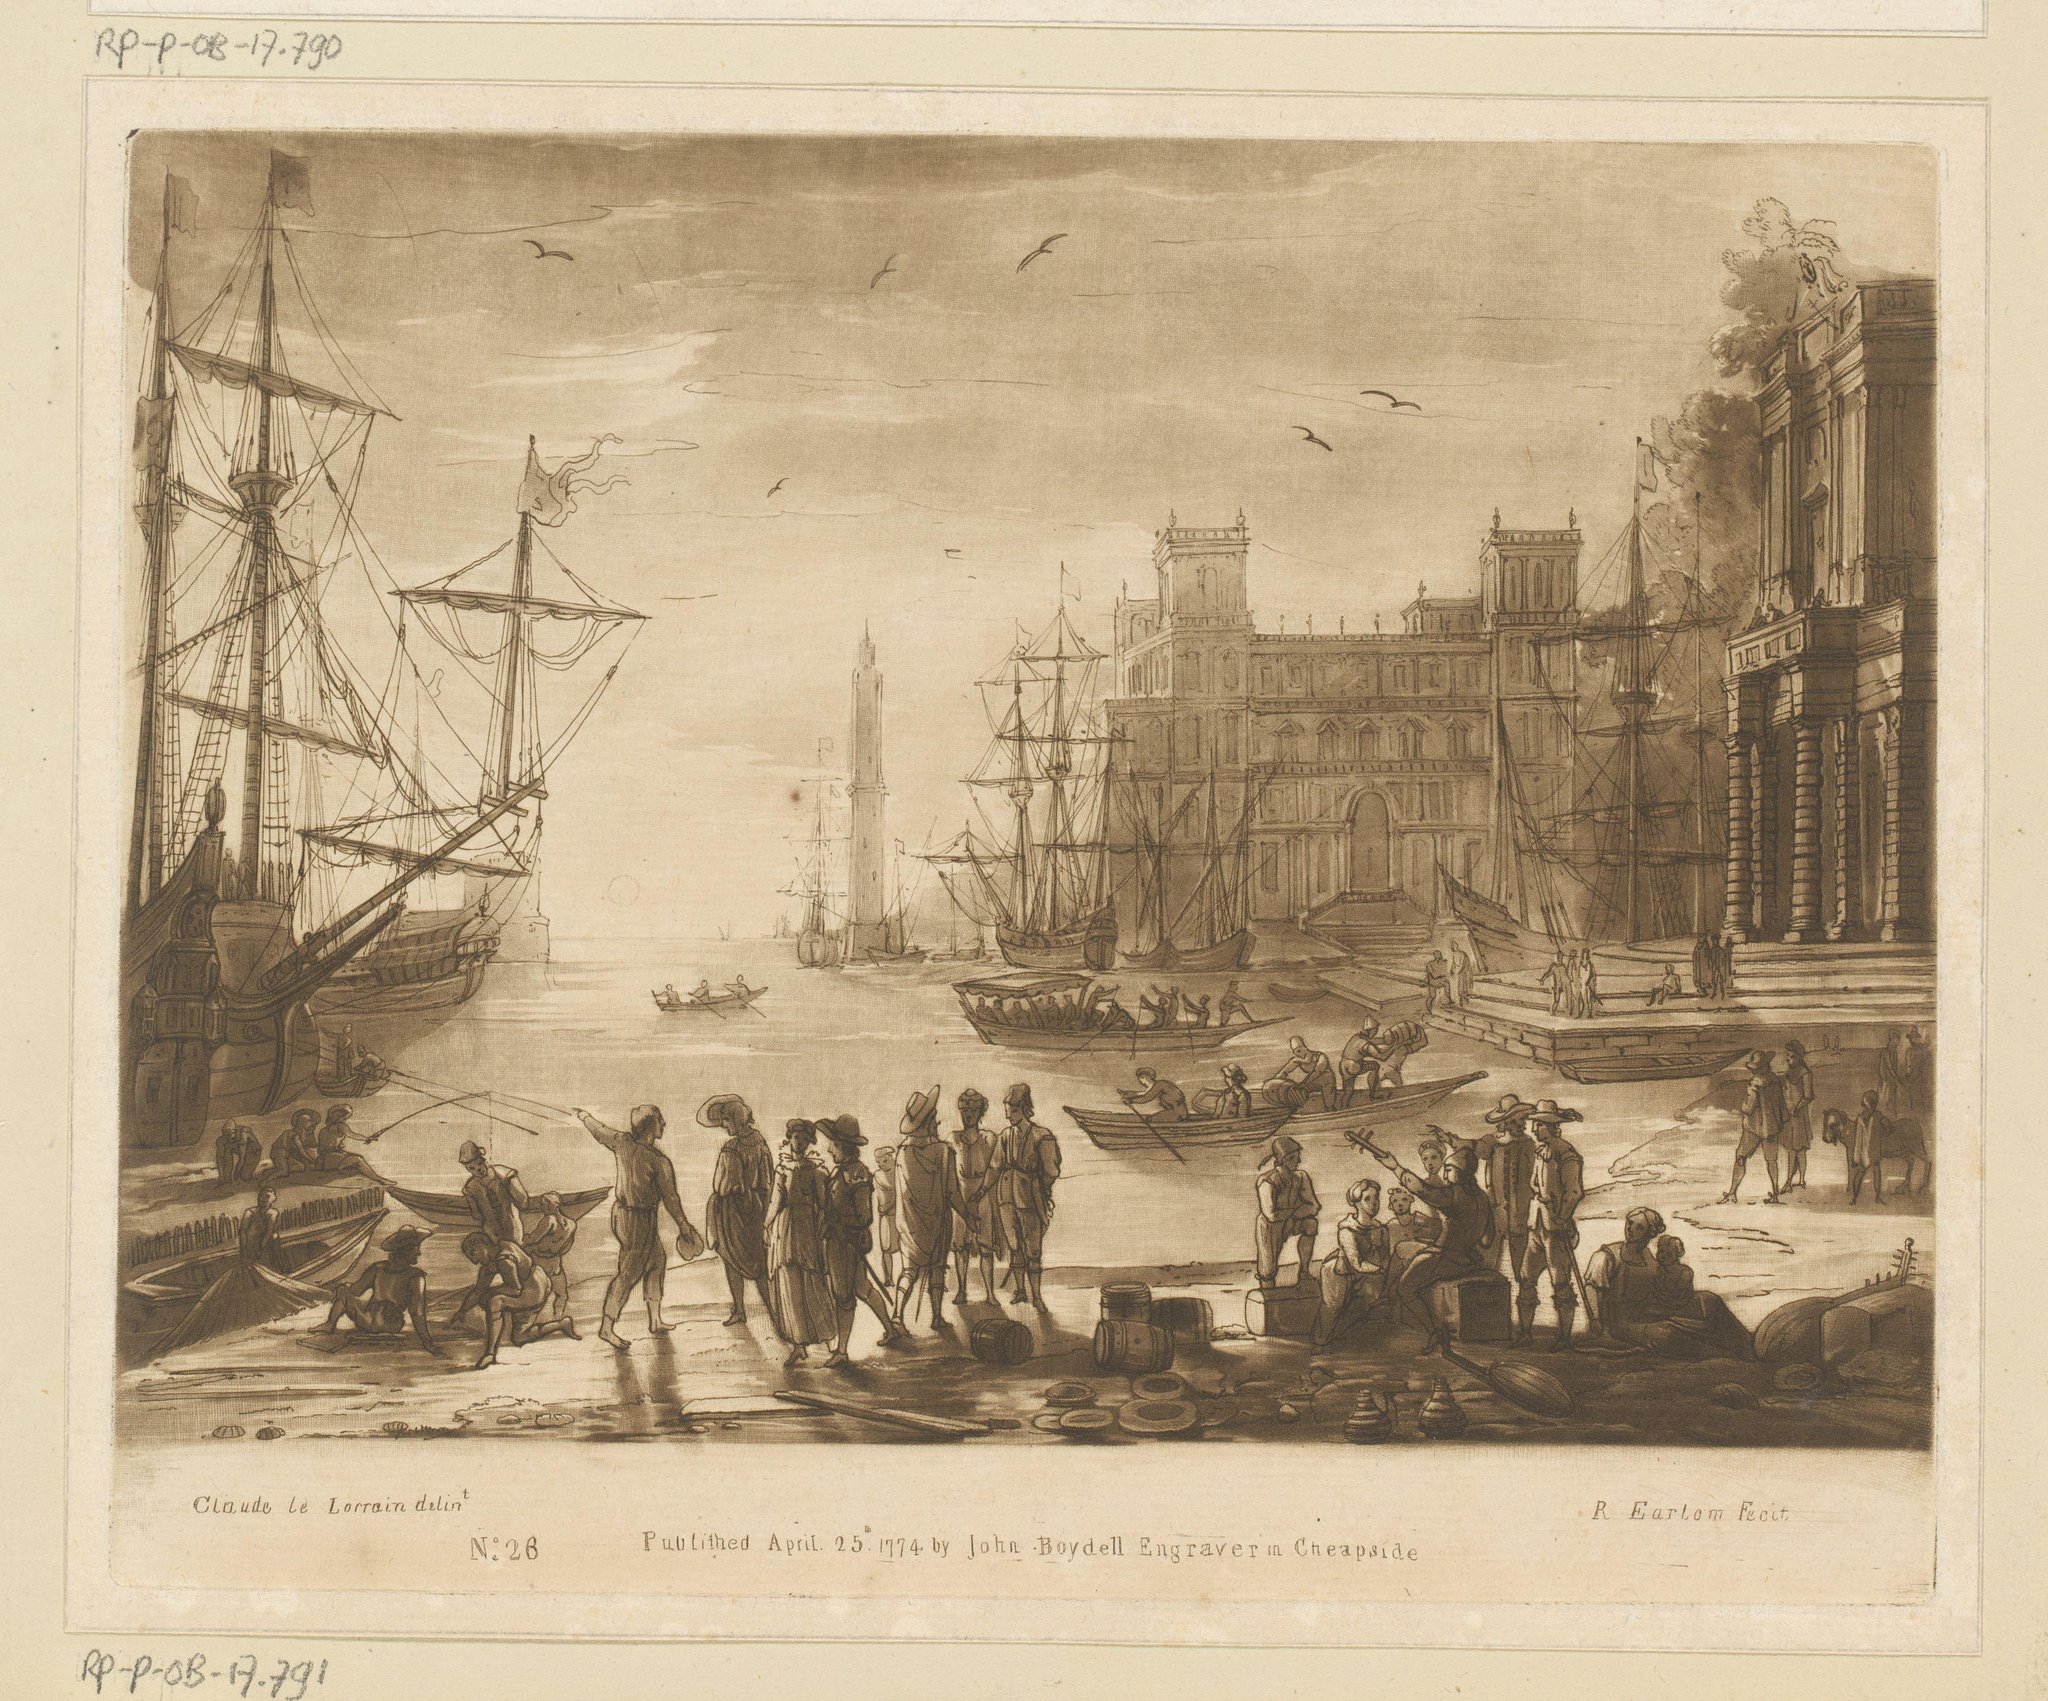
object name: print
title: Liber Veritatis. Or a Collection of Two Hundred Prints, after the original designs of Claude le Lorrain (...)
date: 1774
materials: paper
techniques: etching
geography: london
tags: sailing-ship, sailing-boat, harbour (+ view ~ vehicle, ship, etc.), sunset, landscapes with waters, waterscapes, seascapes (in the temperate zone) (+ landscape with figures, staffage)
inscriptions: date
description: Vanaf 1774 publiceerde John Boydell tweehonderd prenten naar het tekeningenboek Liber Veritatis van Claude Lorrain, in het bezit van de hertogen van Cavendish. Deze prenten werden vanaf 1777 in twee volumes gebundeld uitgegeven.